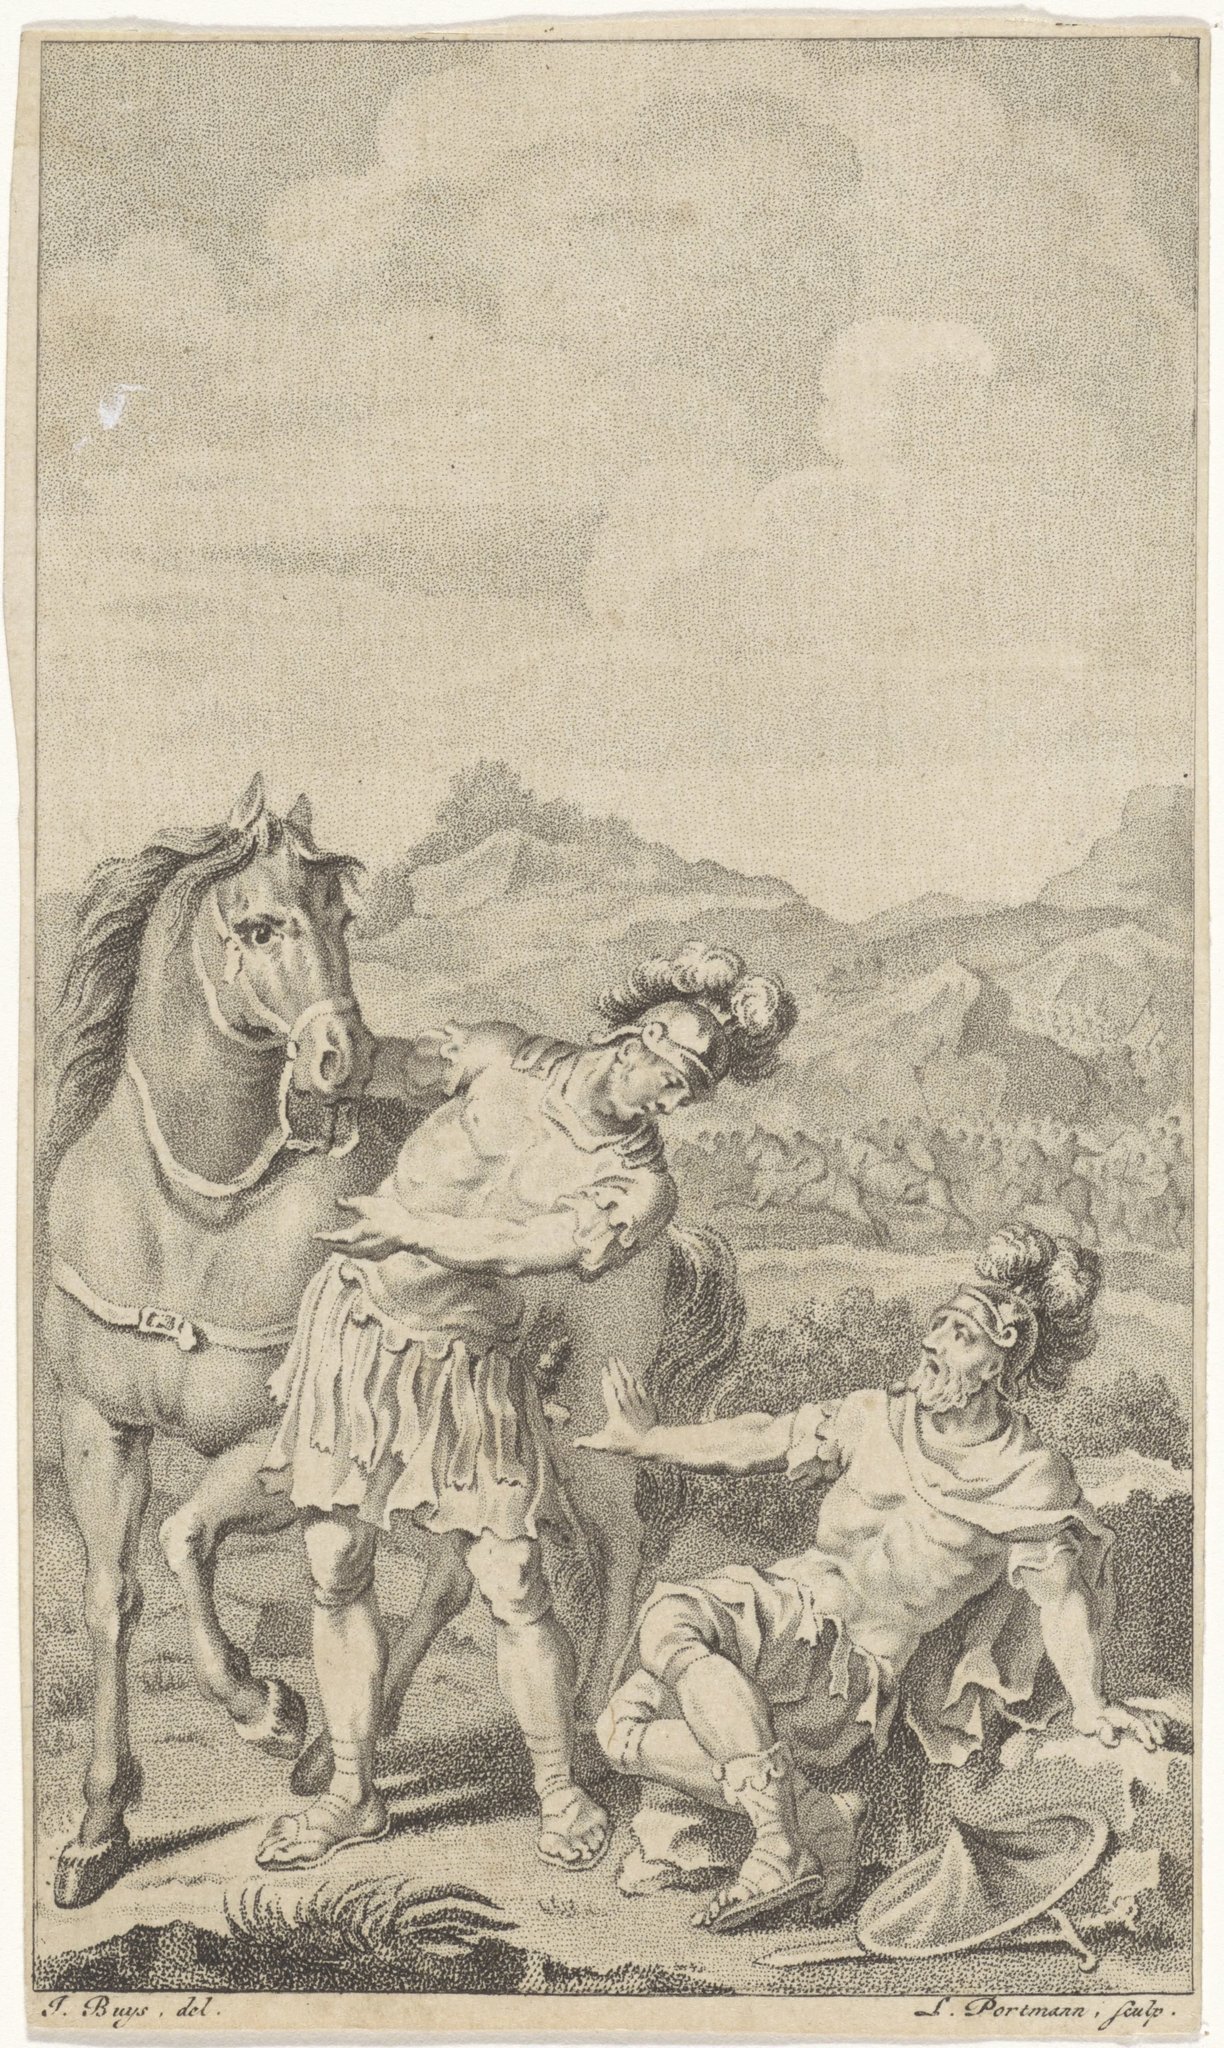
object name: print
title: Dood van Lucius Emilius Paulus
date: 1795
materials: paper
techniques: stippled etching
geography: amsterdam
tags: (story of) lucius aemilius paul(l)us - death of person from classical history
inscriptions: collector's mark: Lugt 2228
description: Een Romeinse soldaat die wegvlucht voor de vijand ziet de stervende Lucius Emilius Paulus liggen. Hij biedt hem zijn paard aan. Lucius Emilius Paulus weigert echter en draagt de soldaat op zelf weg te vluchten.